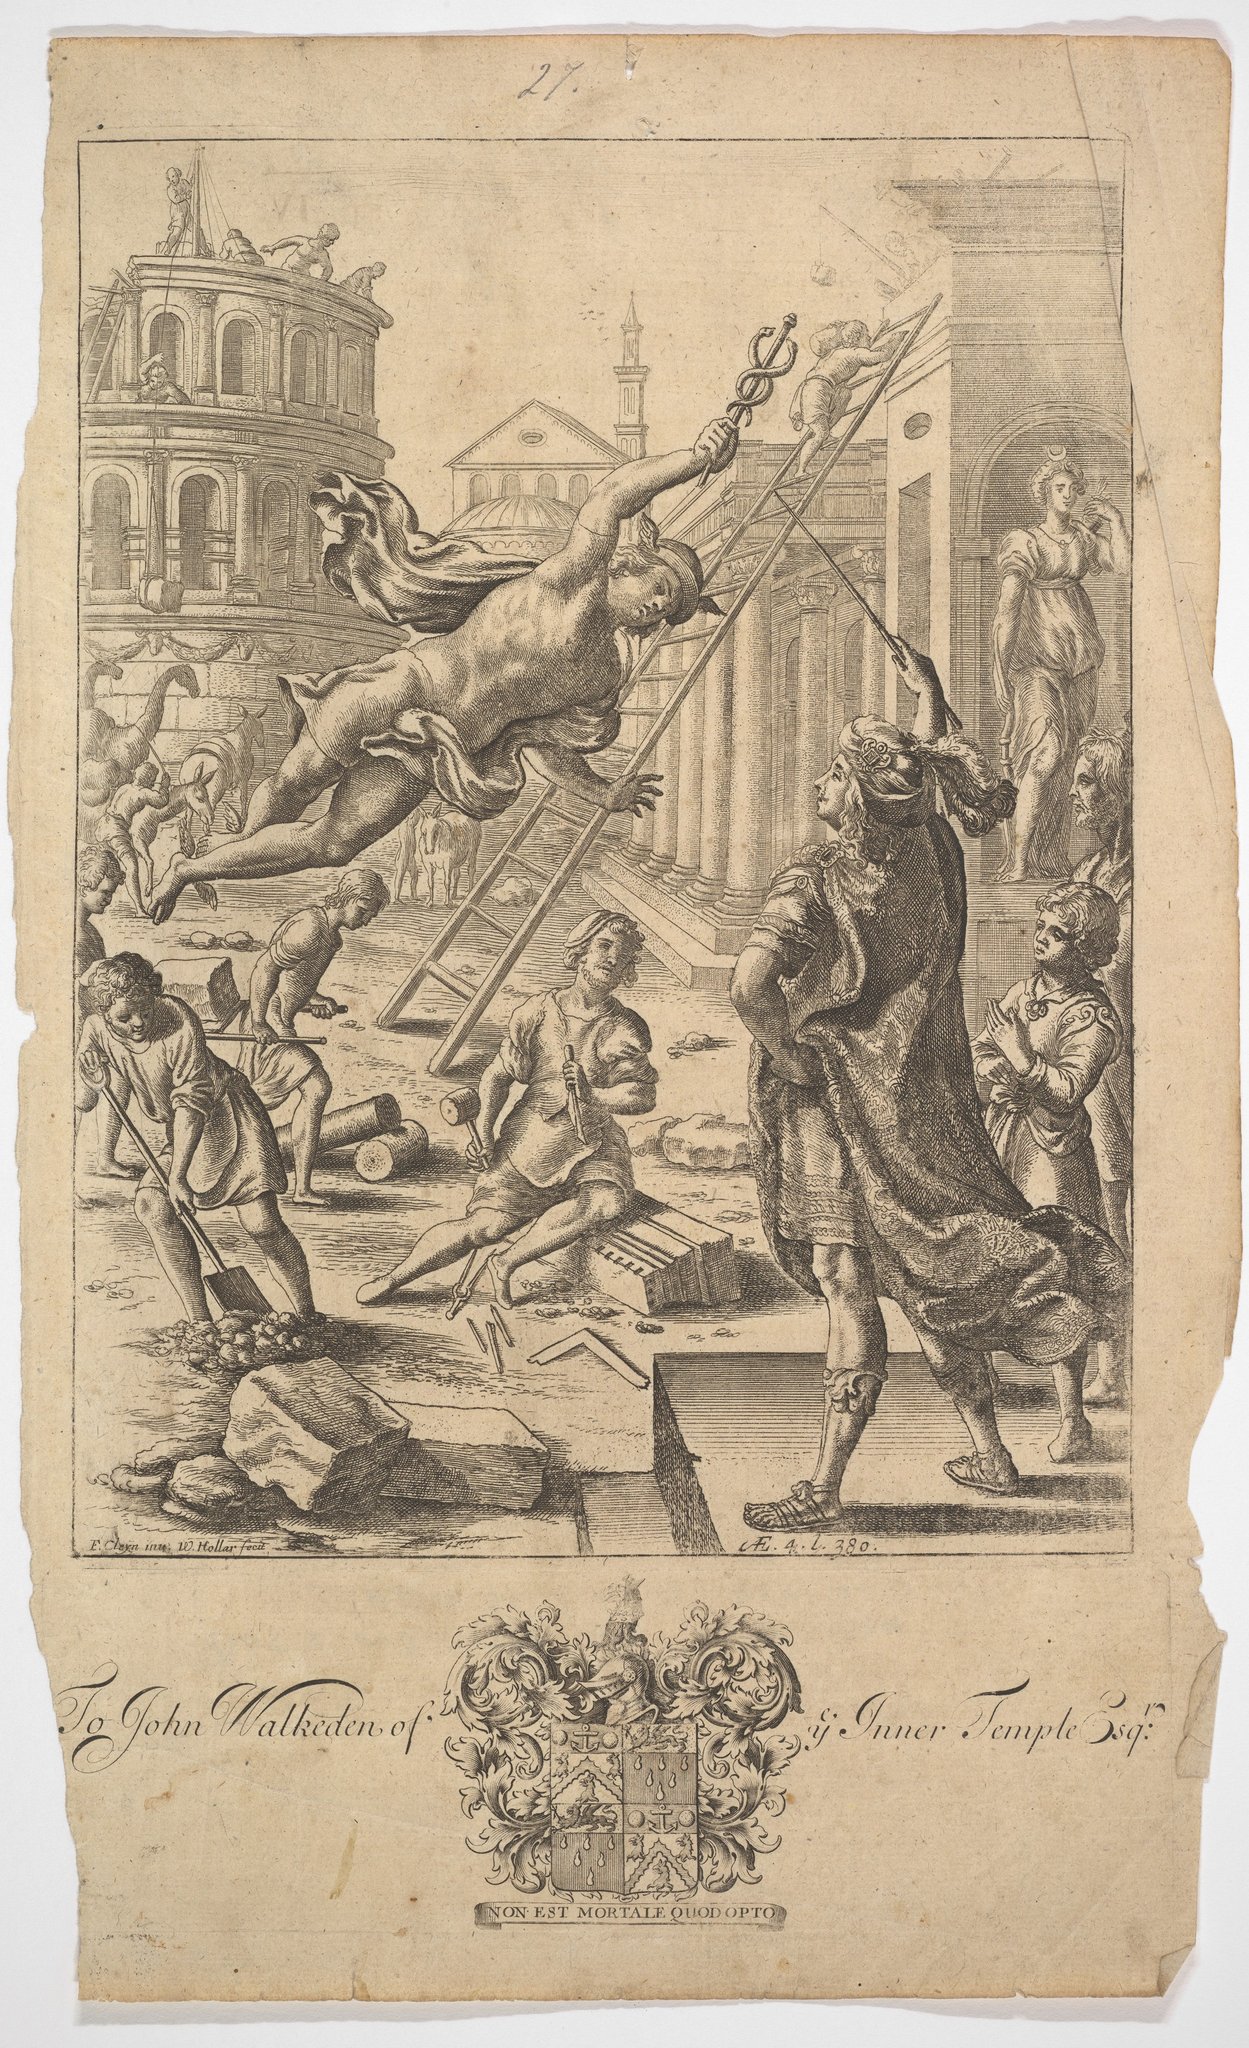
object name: print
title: Aeneas and Mercury (from "The Works of Virgil: Containing his Pastorals, Georgics and Aeneis," 1697)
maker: wenceslaus hollar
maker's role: artist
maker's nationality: bohemian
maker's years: 1607-1677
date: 1654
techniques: engraving, etching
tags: ruins,aeneas,mercury,coat of arms,ladders